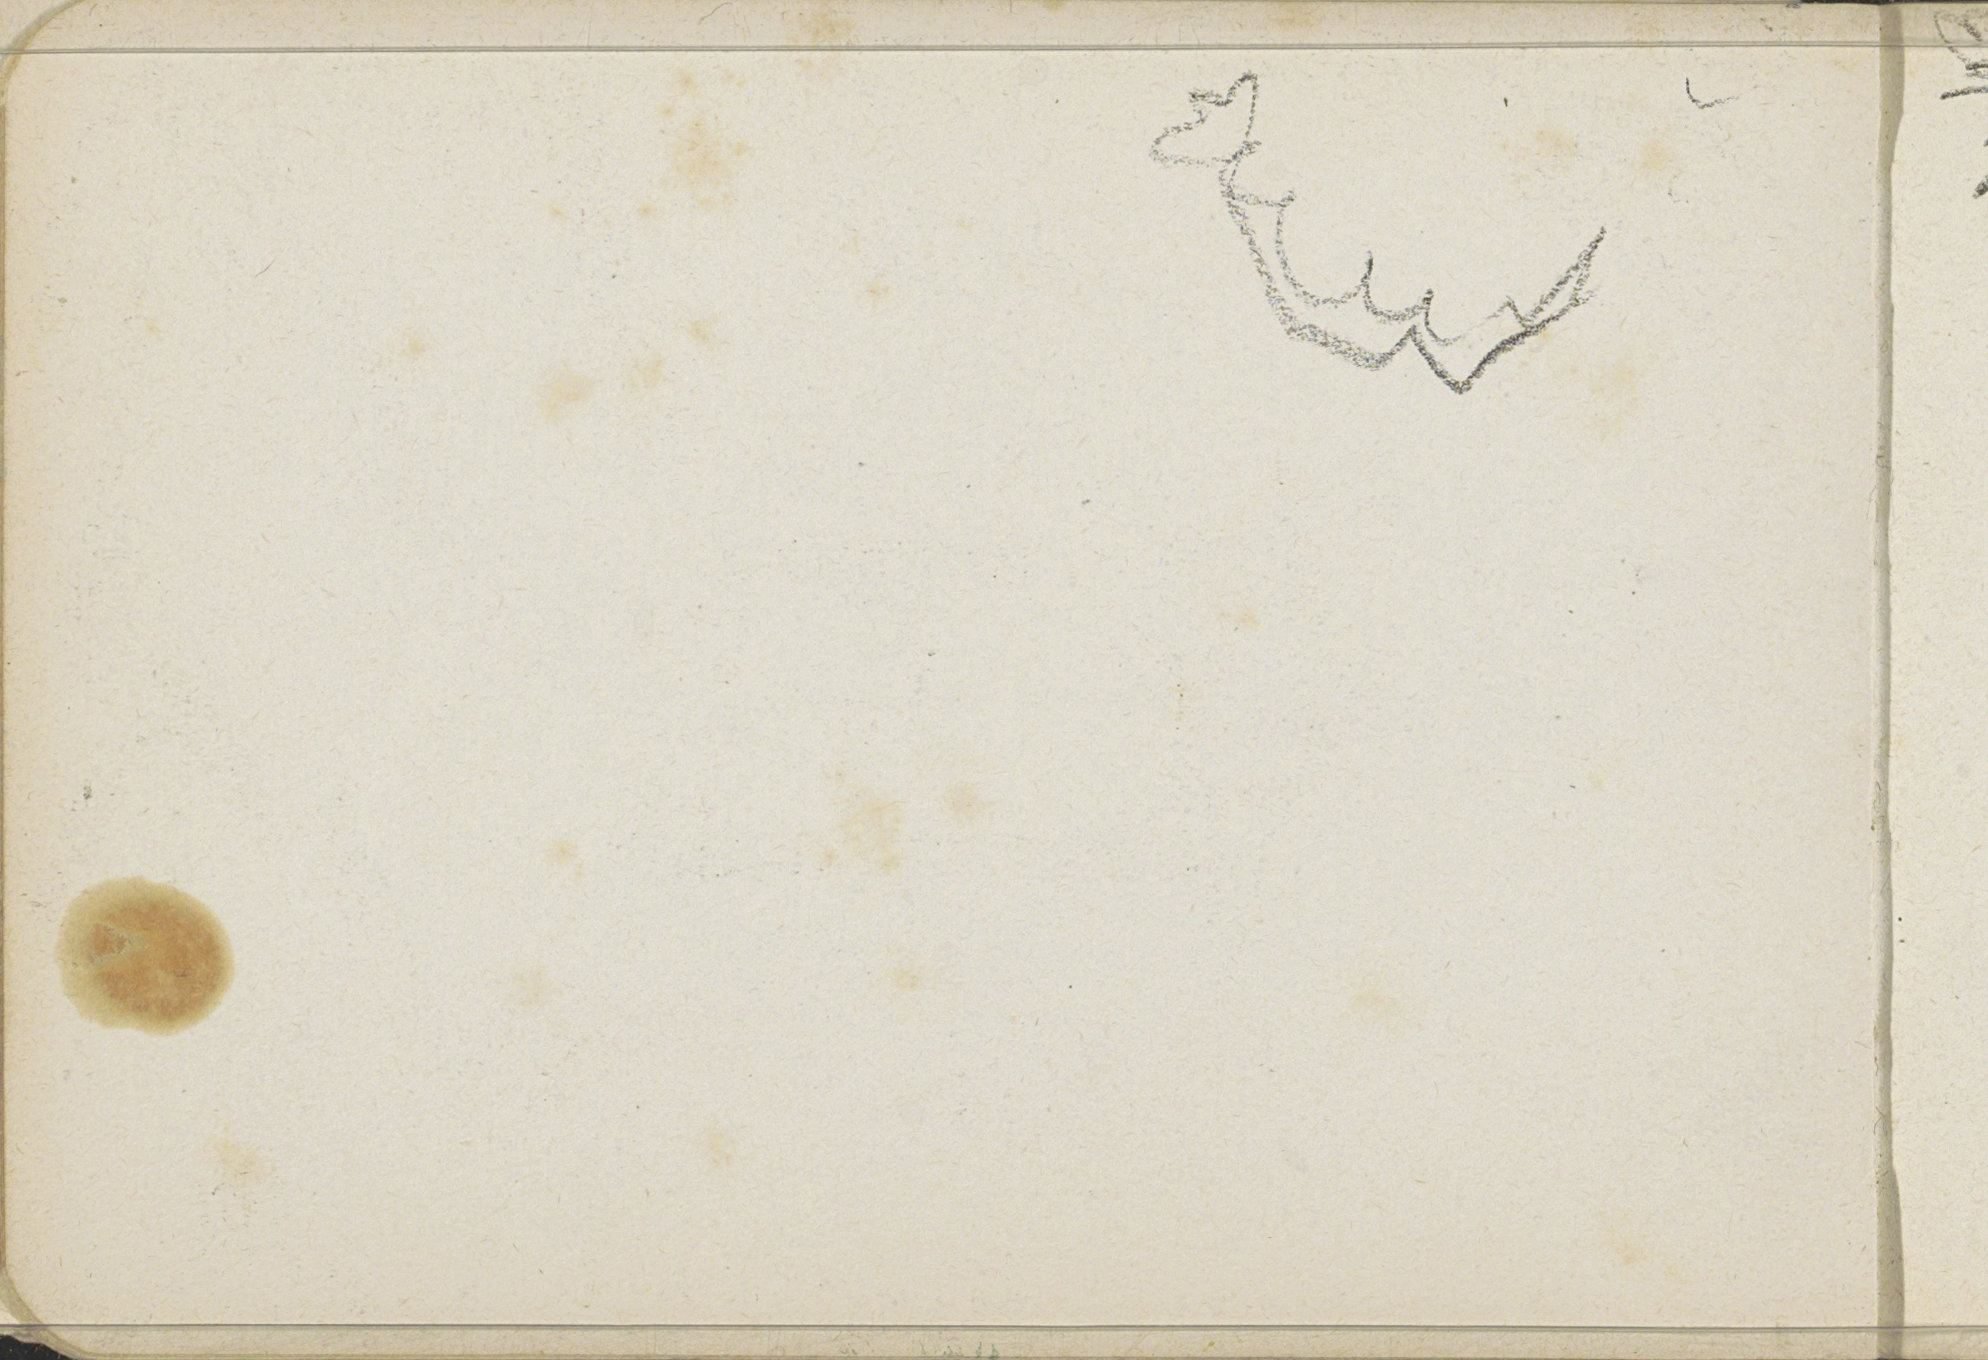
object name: sketchbook leaf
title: Studie, mogelijk bladeren van een boom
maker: willem cornelis rip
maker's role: draughtsman, painter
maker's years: 1856-1922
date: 1866-1922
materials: chalk, paper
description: Blad 17 verso uit een schetsboek met 44 bladen.